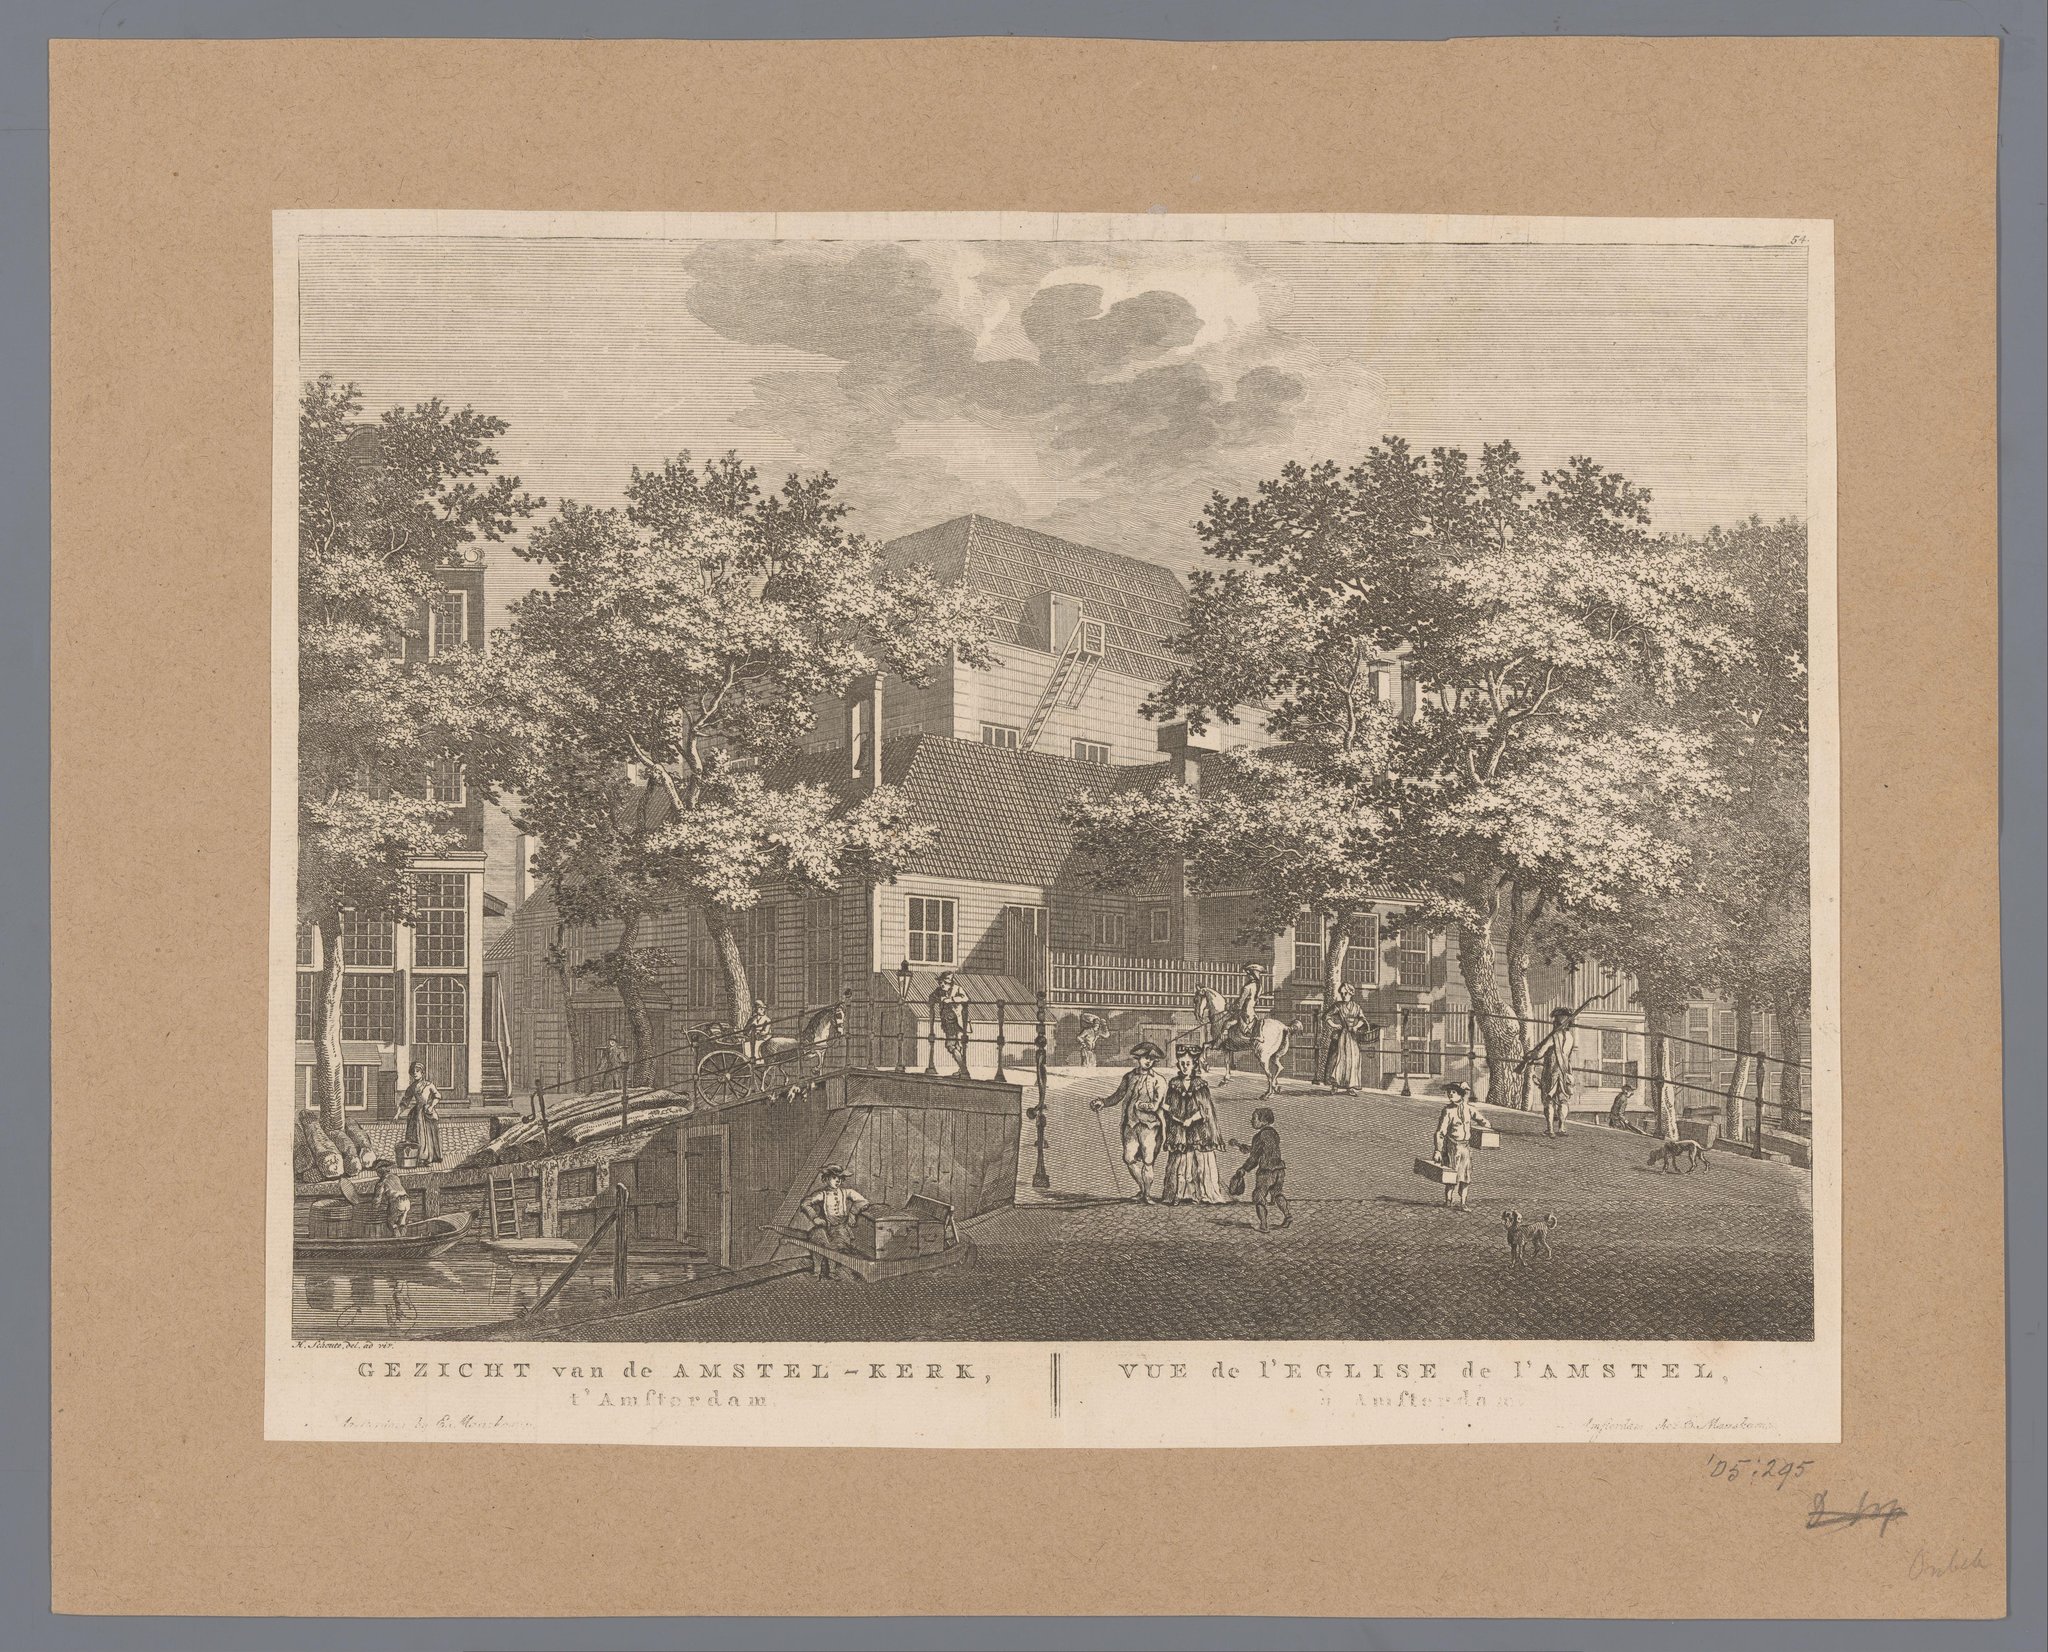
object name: print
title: Gezicht van de Amstel-Kerk, t' Amsterdam / Vue de l'Eglise de l'Amstel, à Amsterdam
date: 1805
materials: paper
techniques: etching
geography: amsterdam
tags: bridge in city across river, canal, etc. (+ city(-scape) with figures, staffage), church (exterior)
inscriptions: collector's mark: Lugt 2228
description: Prent uit: Nieuwe atlas, van de voornaamste gebouwen en gezigten der stad Amsterdam. Met derzelver beknopte beschryvingen. Amsterdam: Evert Maaskamp, 1805. De prent werd eerder uitgegeven door Pierre Fouquet als onderdeel van de zogenaamde Atlas van Fouquet: stadsgezichten van Amsterdam naar tekeningen van verschillende kunstenaars. Deze prenten werden aanvankelijk (vanaf ca. 1760) los verkocht en later (1783) samengebonden gepubliceerd.